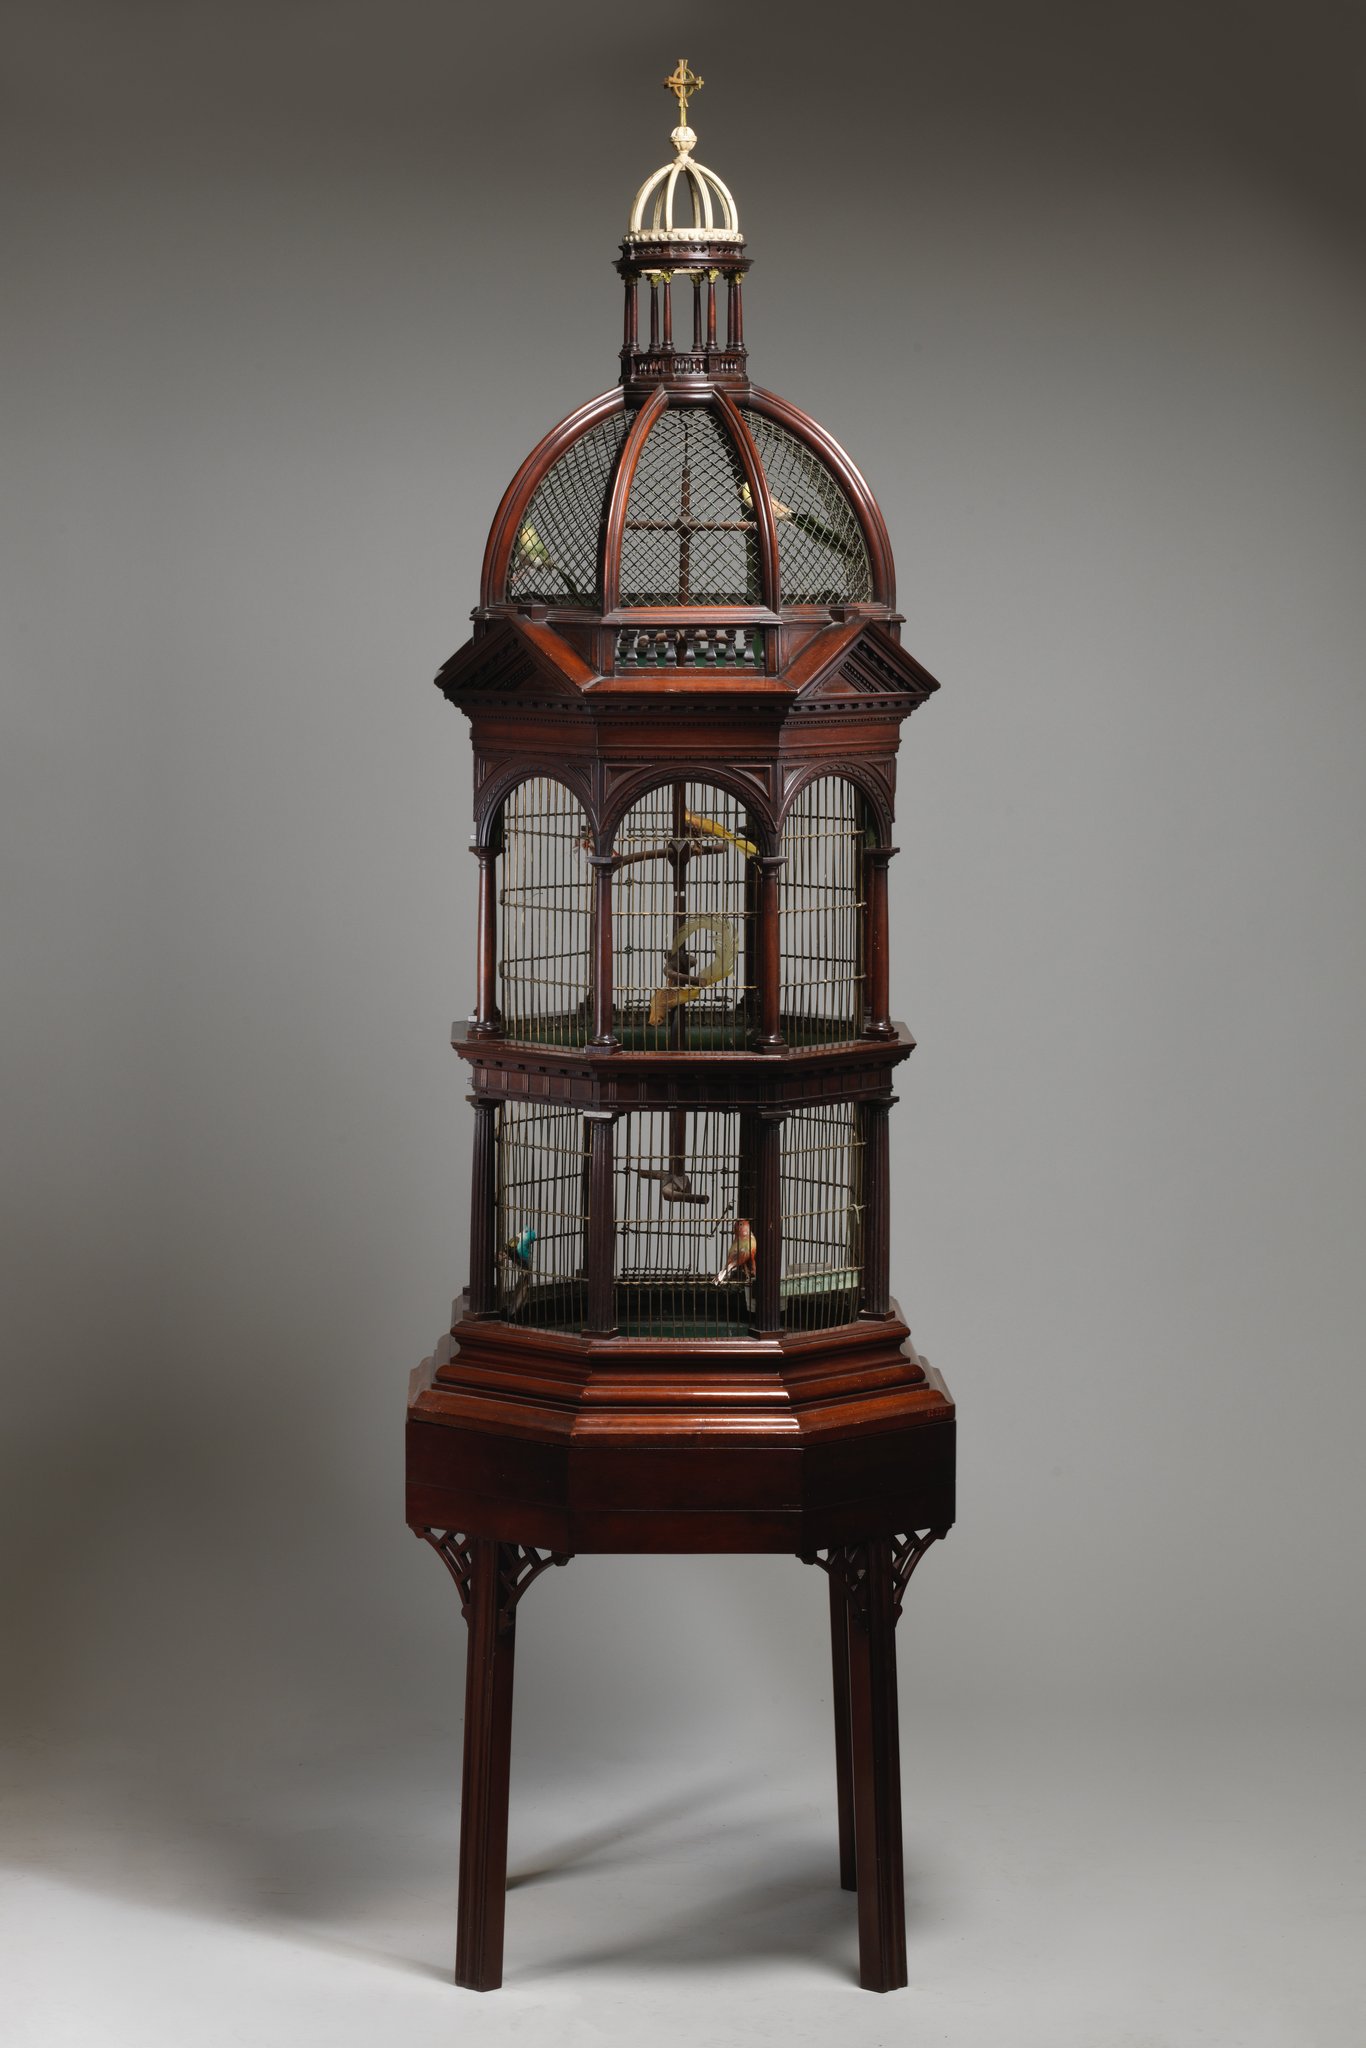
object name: birdcage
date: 1750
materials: brass, wood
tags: birds